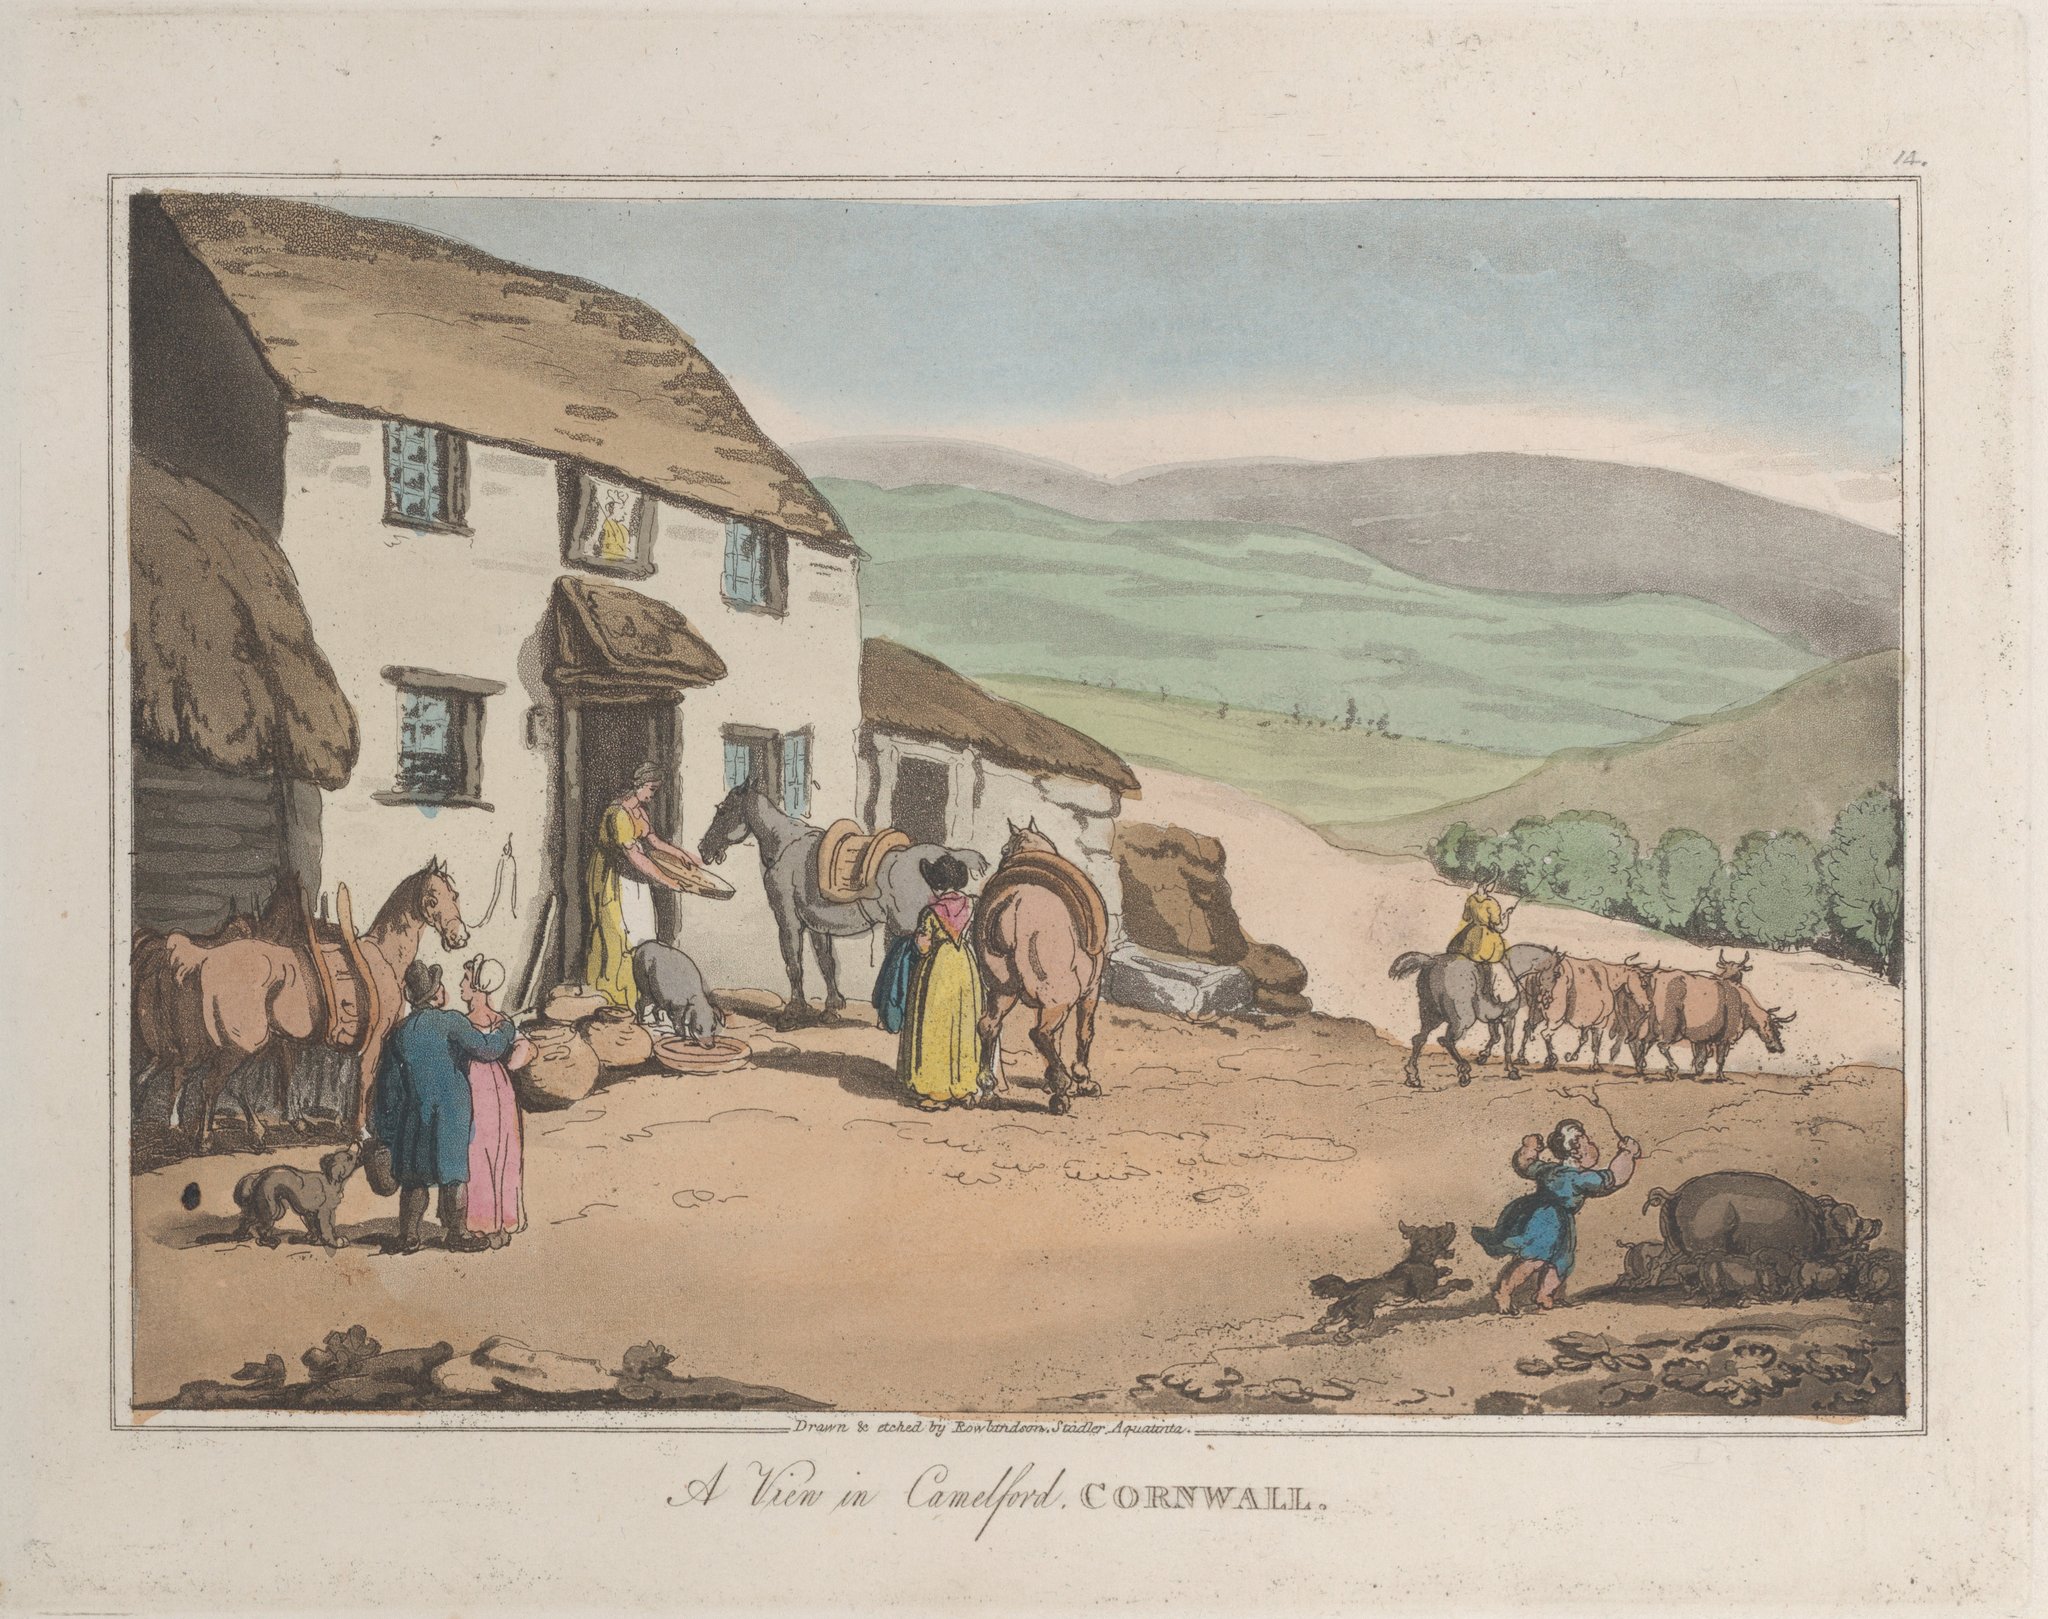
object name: print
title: A View of Camelford, Cornwall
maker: thomas rowlandson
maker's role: artist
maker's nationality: british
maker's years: 1757-1827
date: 1822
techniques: aquatint, etching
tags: houses,cows,dogs,horses,pigs